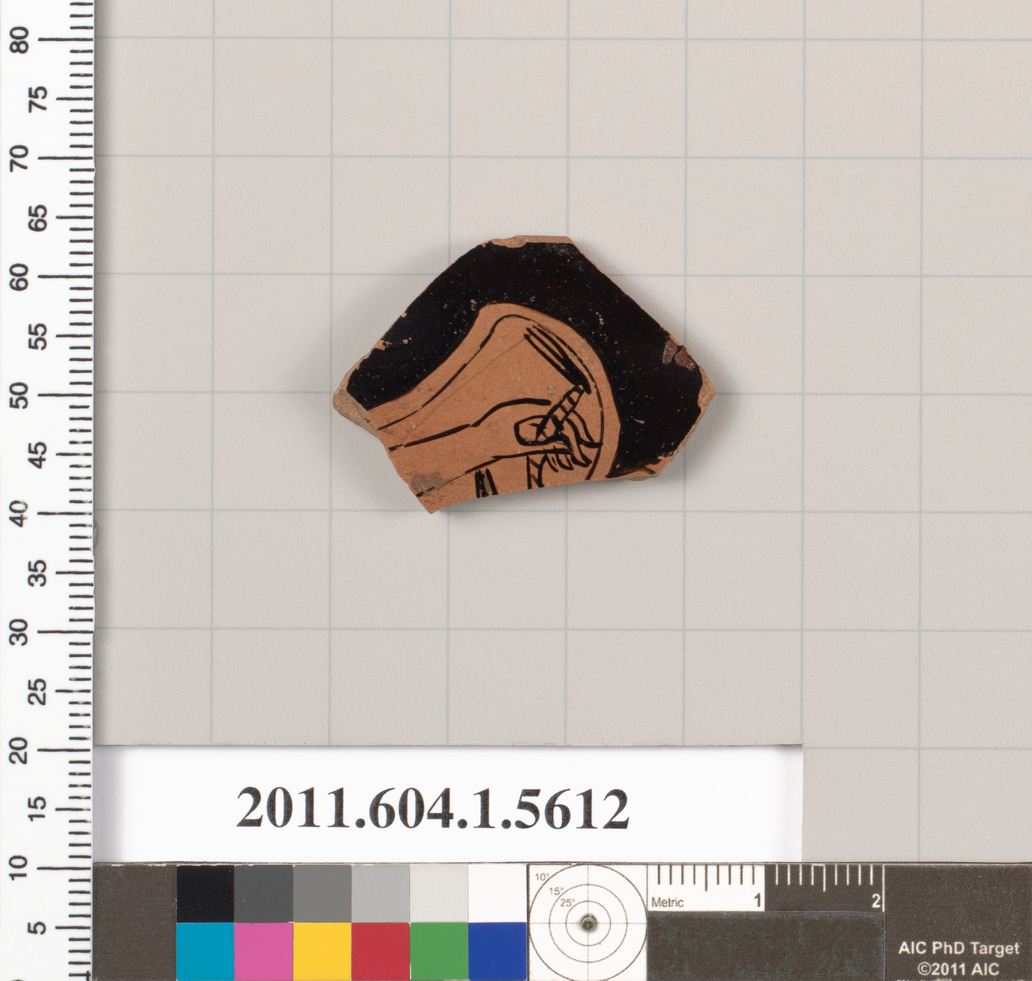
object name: kylix fragment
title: Terracotta rim fragment of a kylix (drinking cup)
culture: greek, attic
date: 520-500 BCE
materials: terracotta